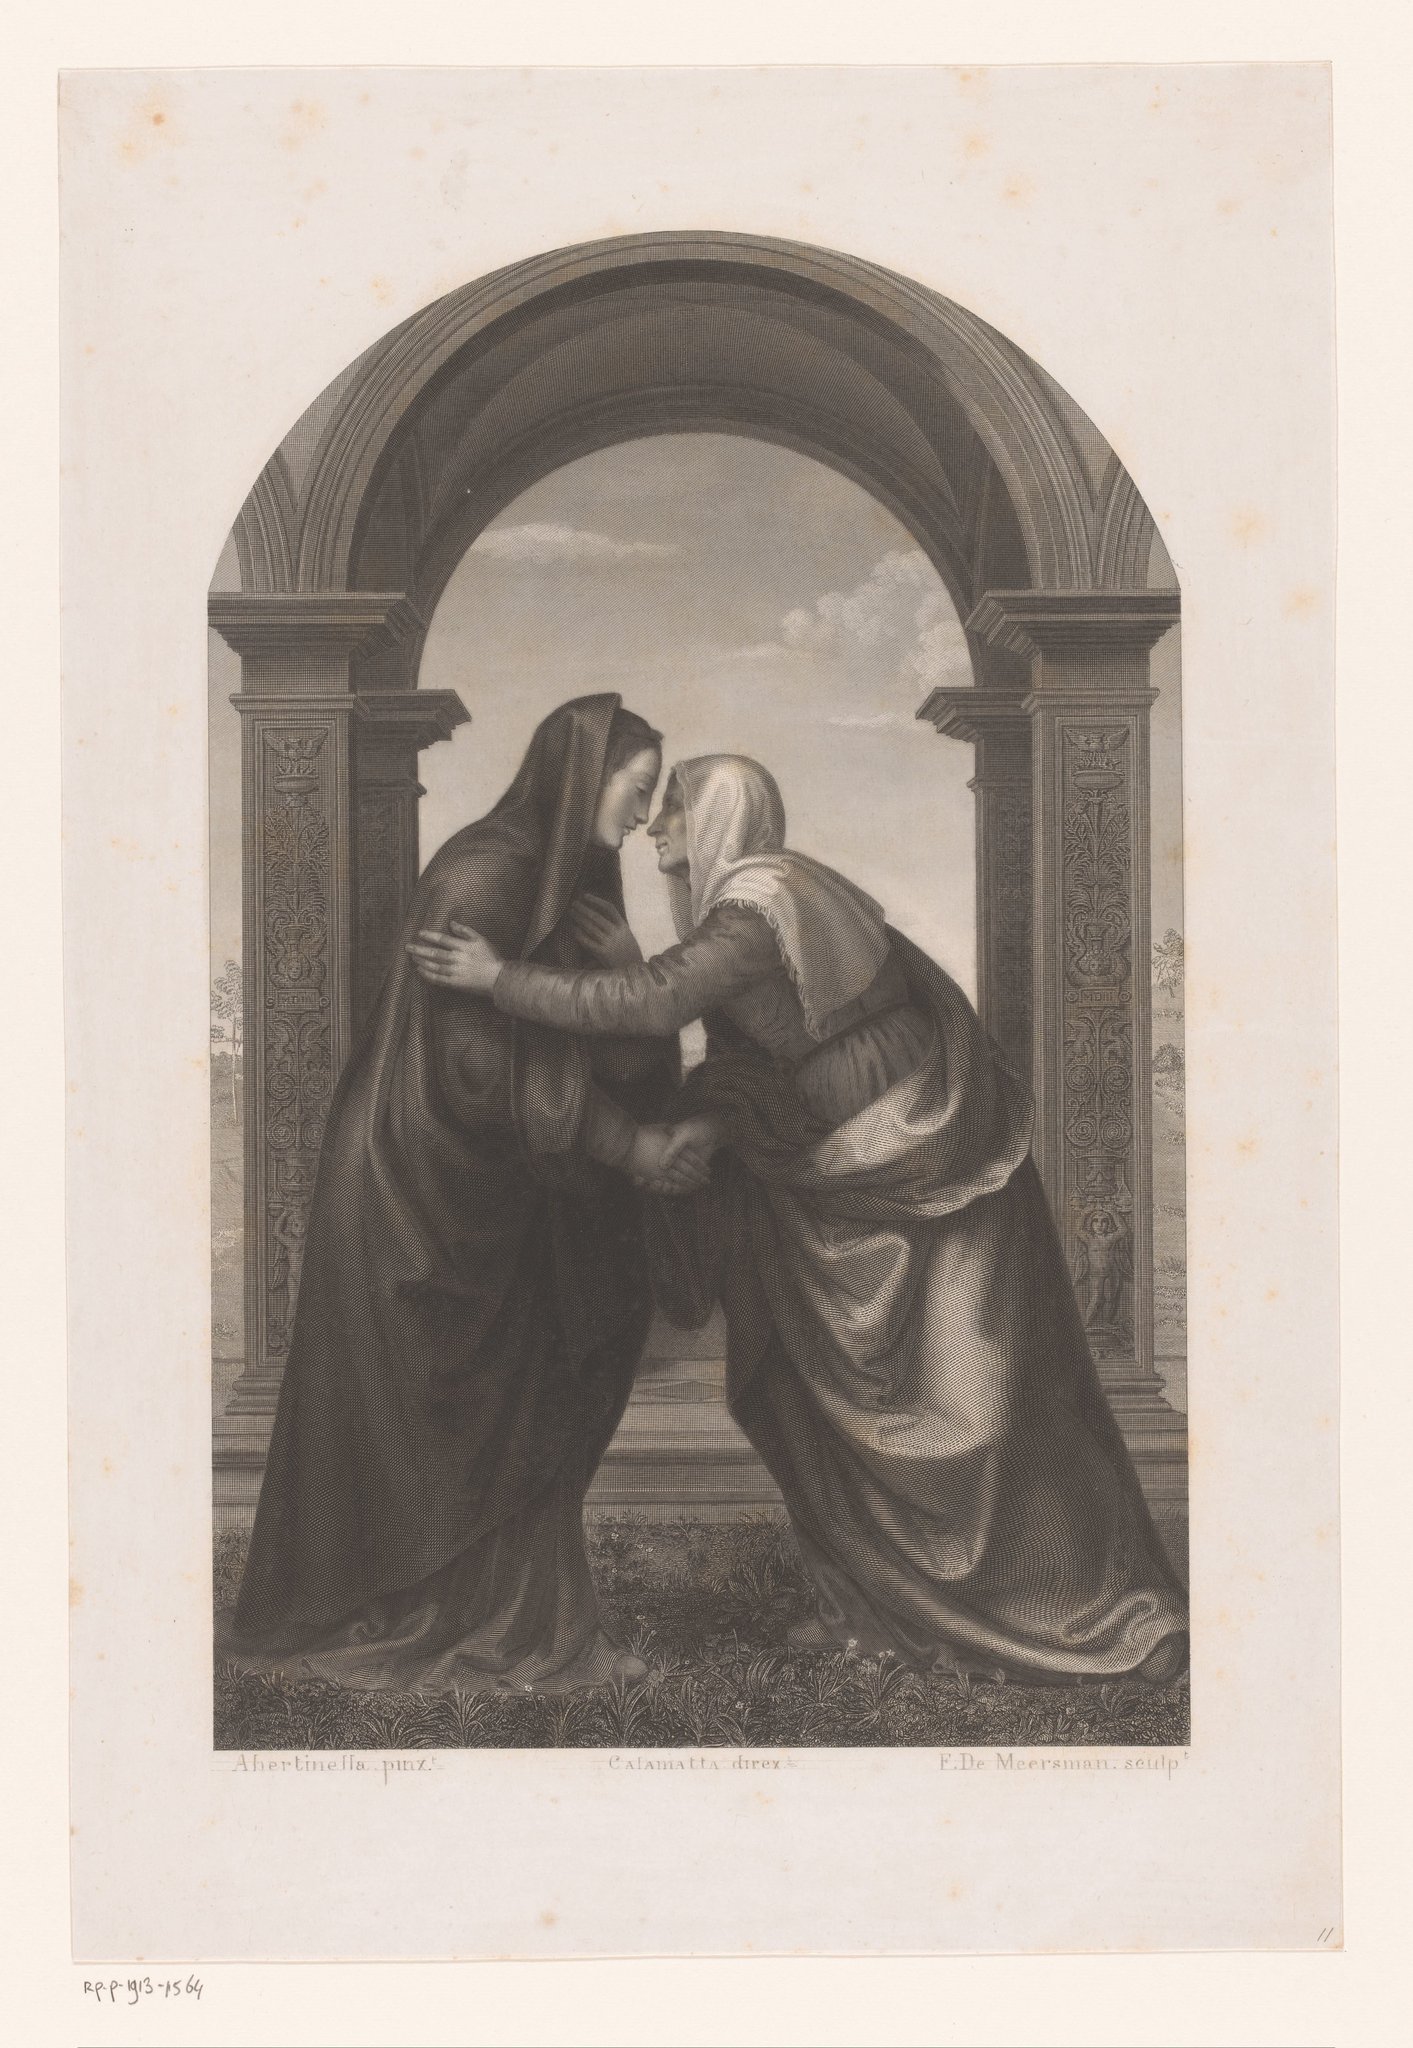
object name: print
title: Visitatie van Maria en Elisabeth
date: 1840-1869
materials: paper, pencil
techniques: engraving, etching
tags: mary and elisabeth shaking hands, triumphal arch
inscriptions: collector's mark: Lugt 2228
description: Maria bezoekt haar nicht Elisabeth. Beiden zijn zwanger (Maria van Christus en Elisabeth van Johannes de Doper).